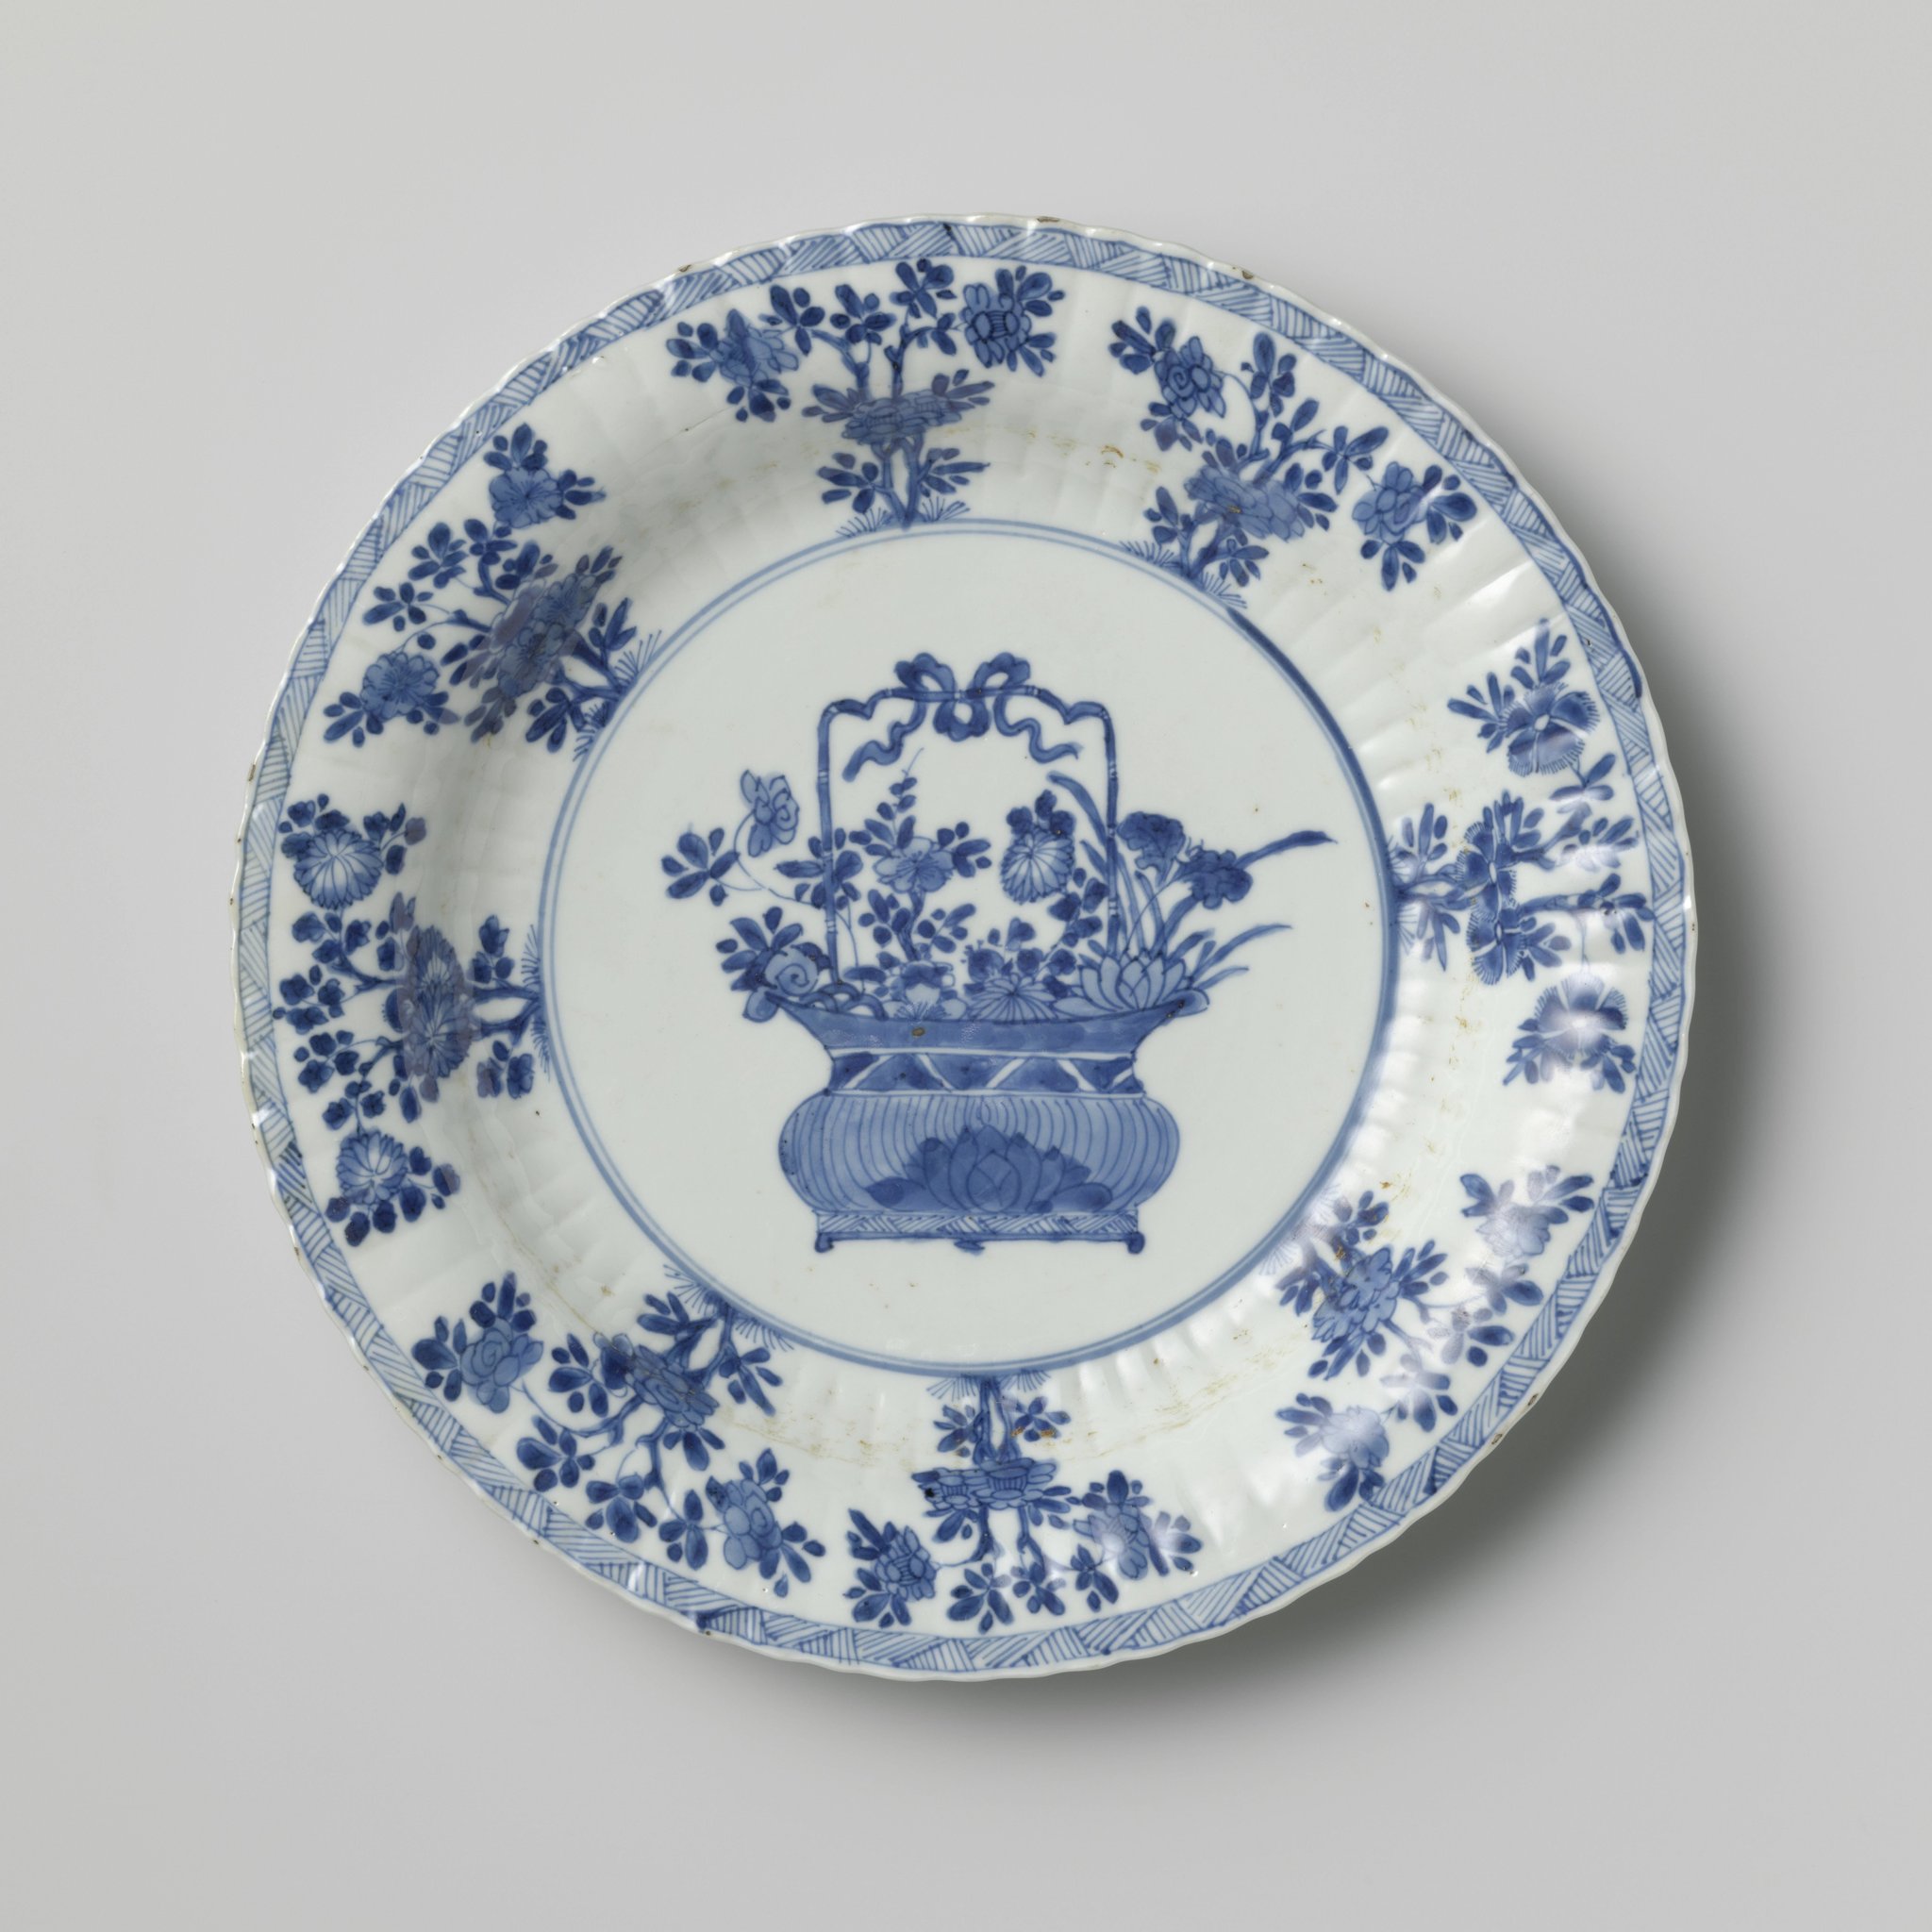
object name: platter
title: Dish with fluted sides, flower basket and flower sprays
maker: Anonymous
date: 1700-1724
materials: cobalt, glaze, paint, porcelain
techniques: firing, turning, vitrification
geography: china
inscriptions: mark